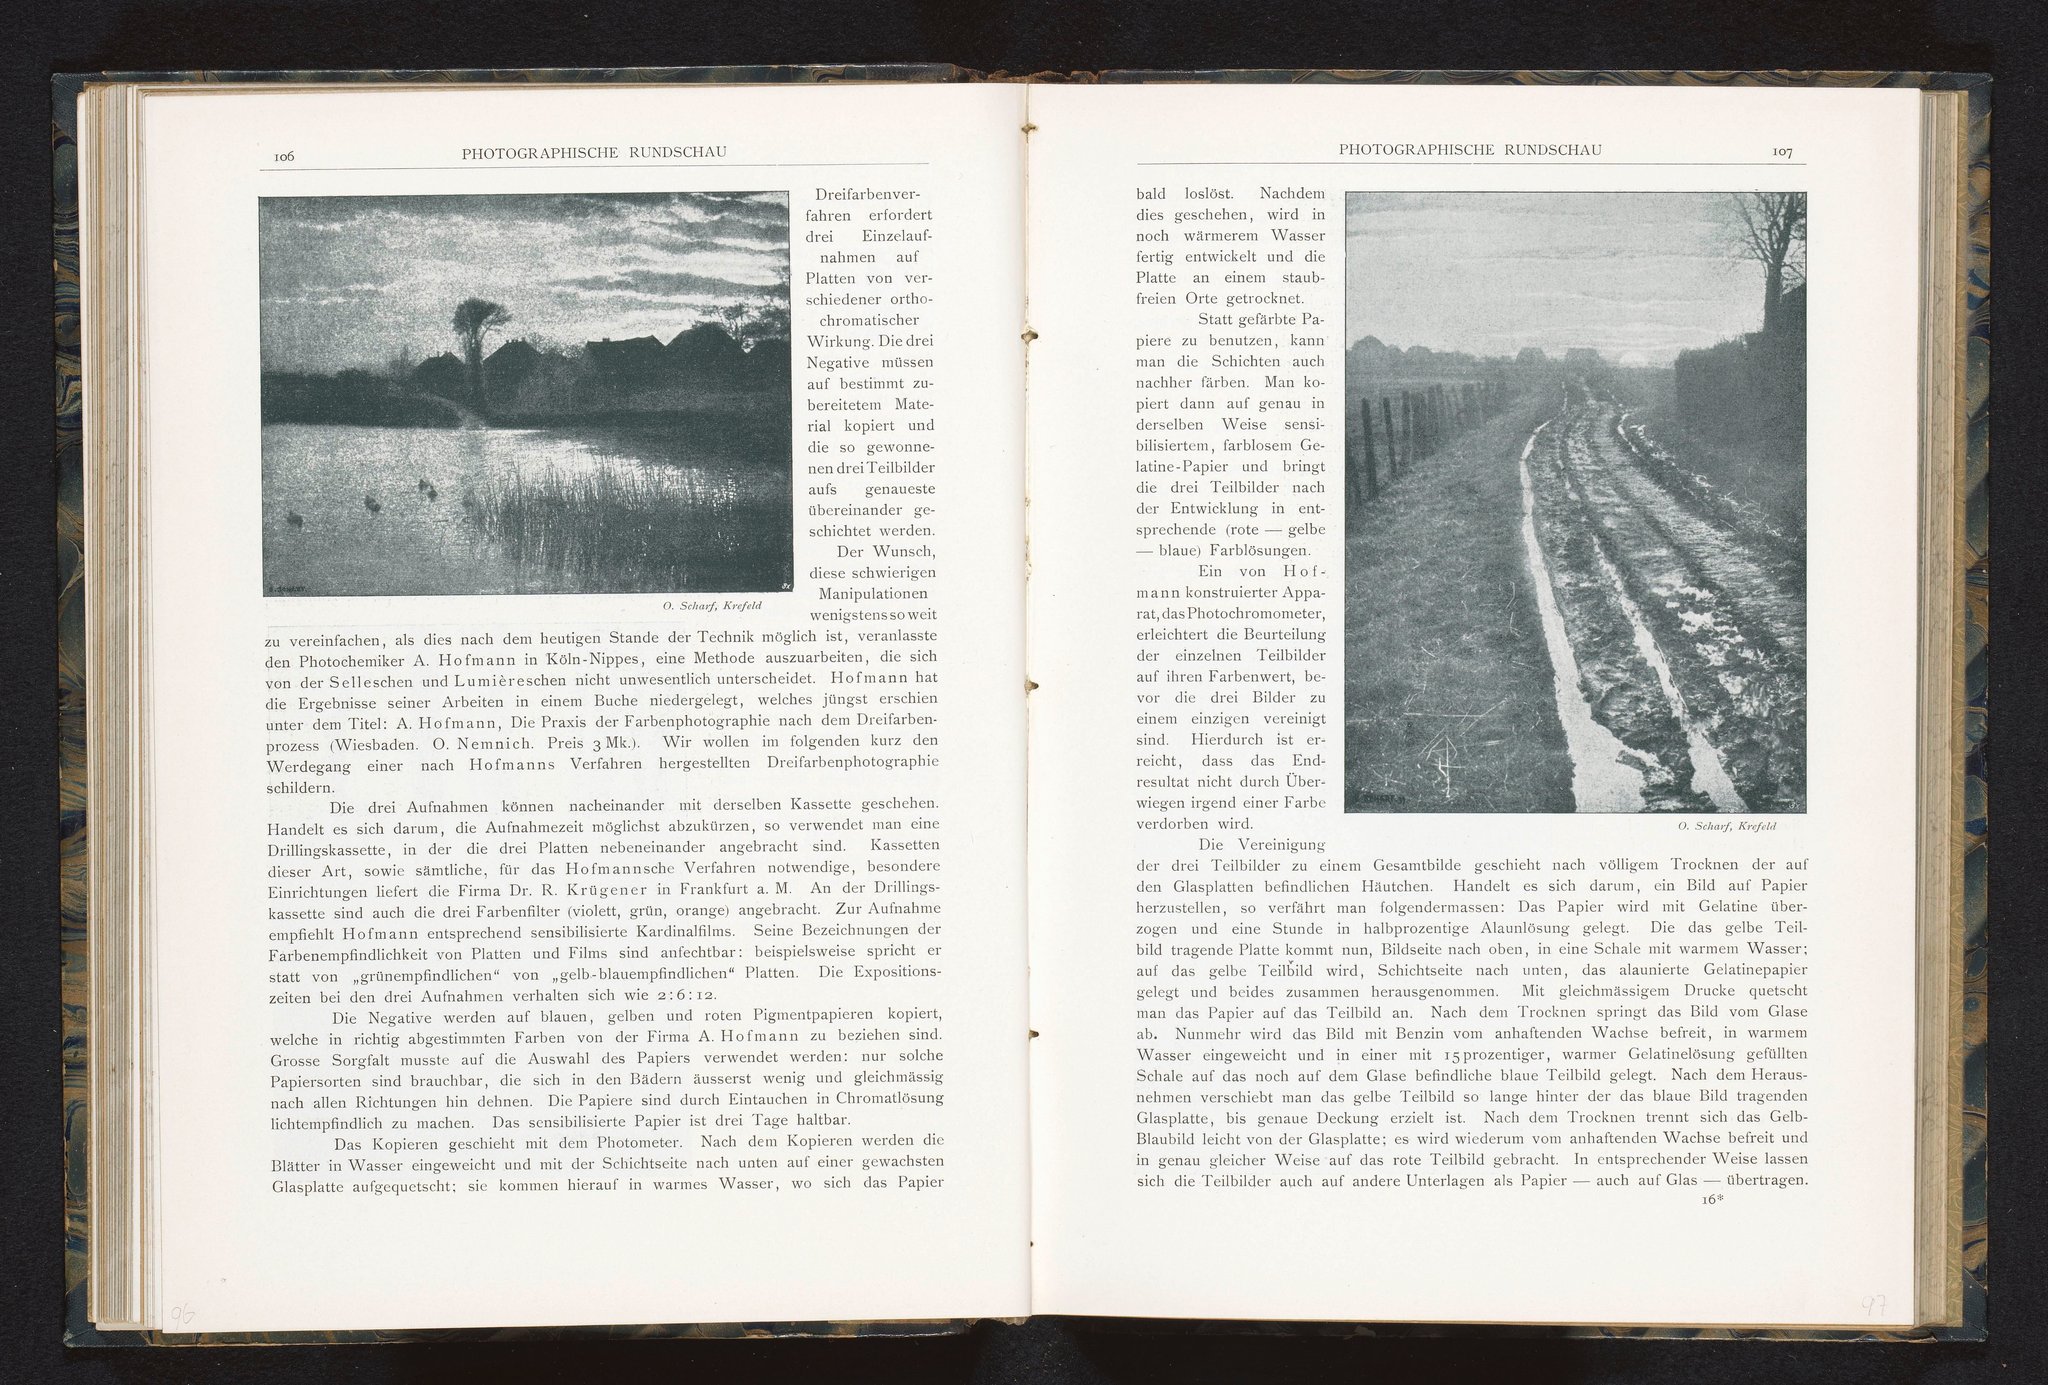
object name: photomechanical print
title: Gezicht op een water met huizen op de achtergrond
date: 1895-1900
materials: paper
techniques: autotype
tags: landscapes with waters, waterscapes, seascapes (in the temperate zone), rural housing, e.g. country-house, villa, cottage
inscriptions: monogram: ‘BX’